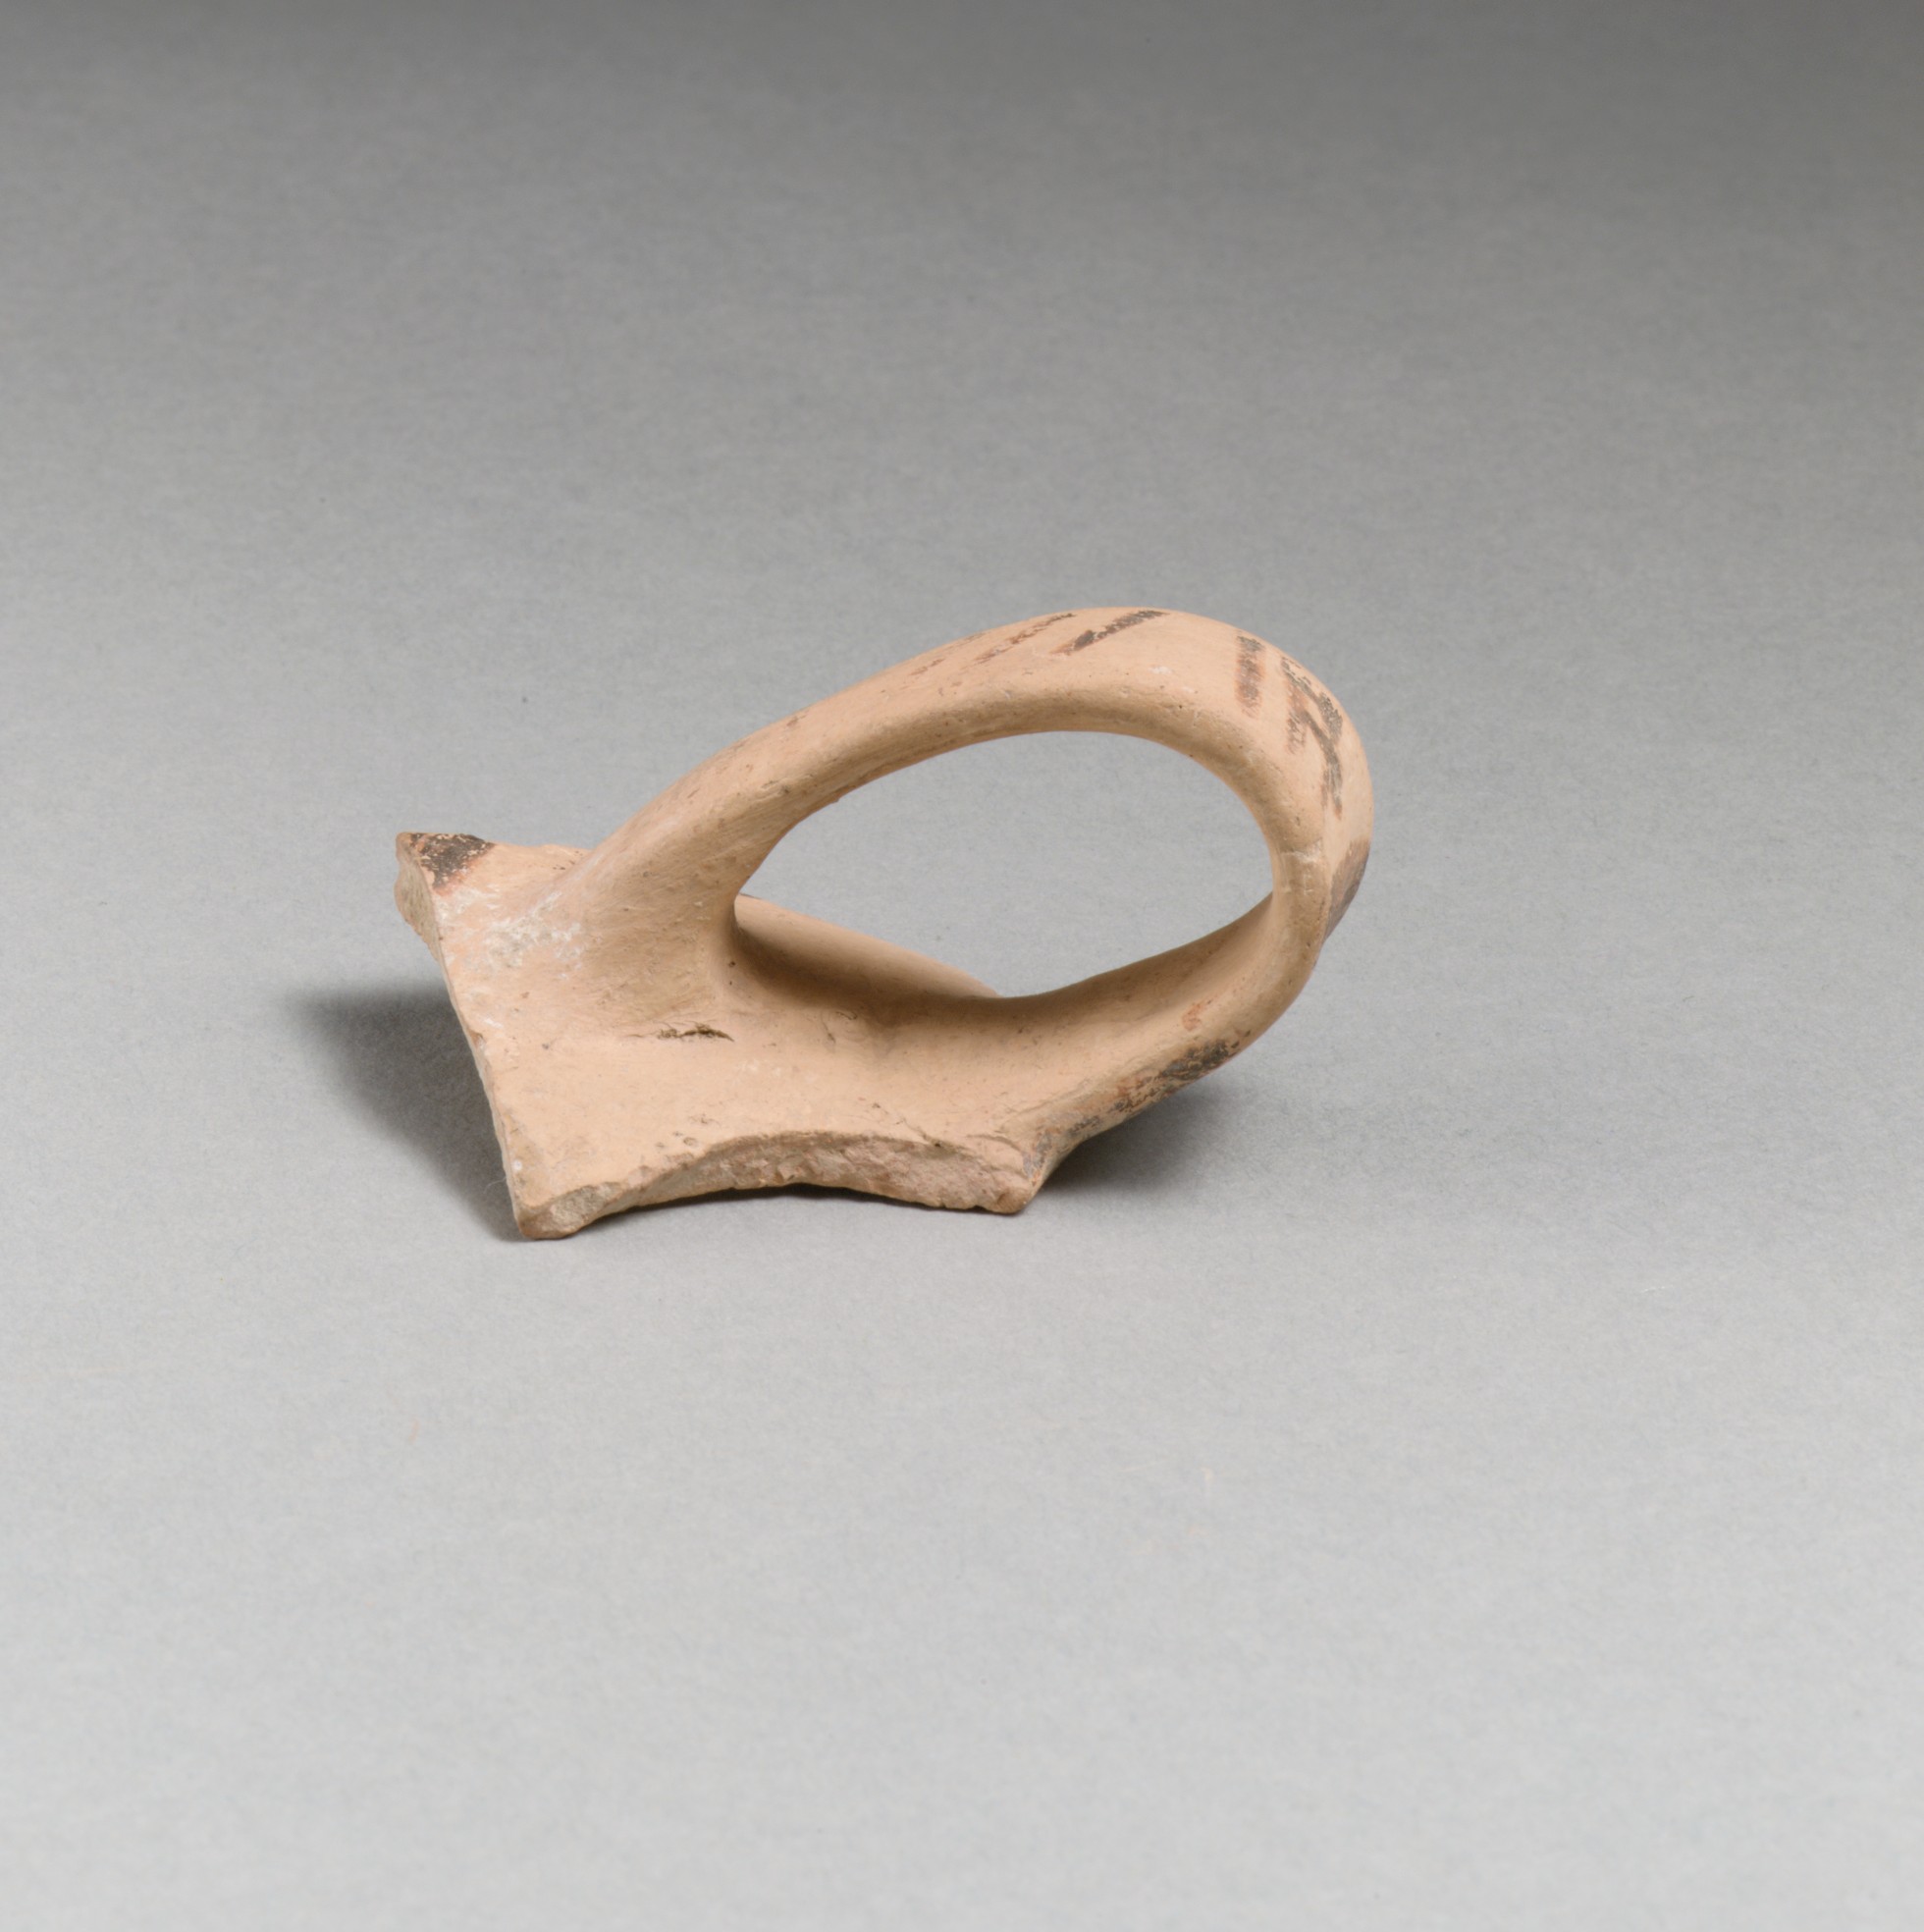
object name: vase fragment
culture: minoan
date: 1600-1450 BCE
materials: terracotta